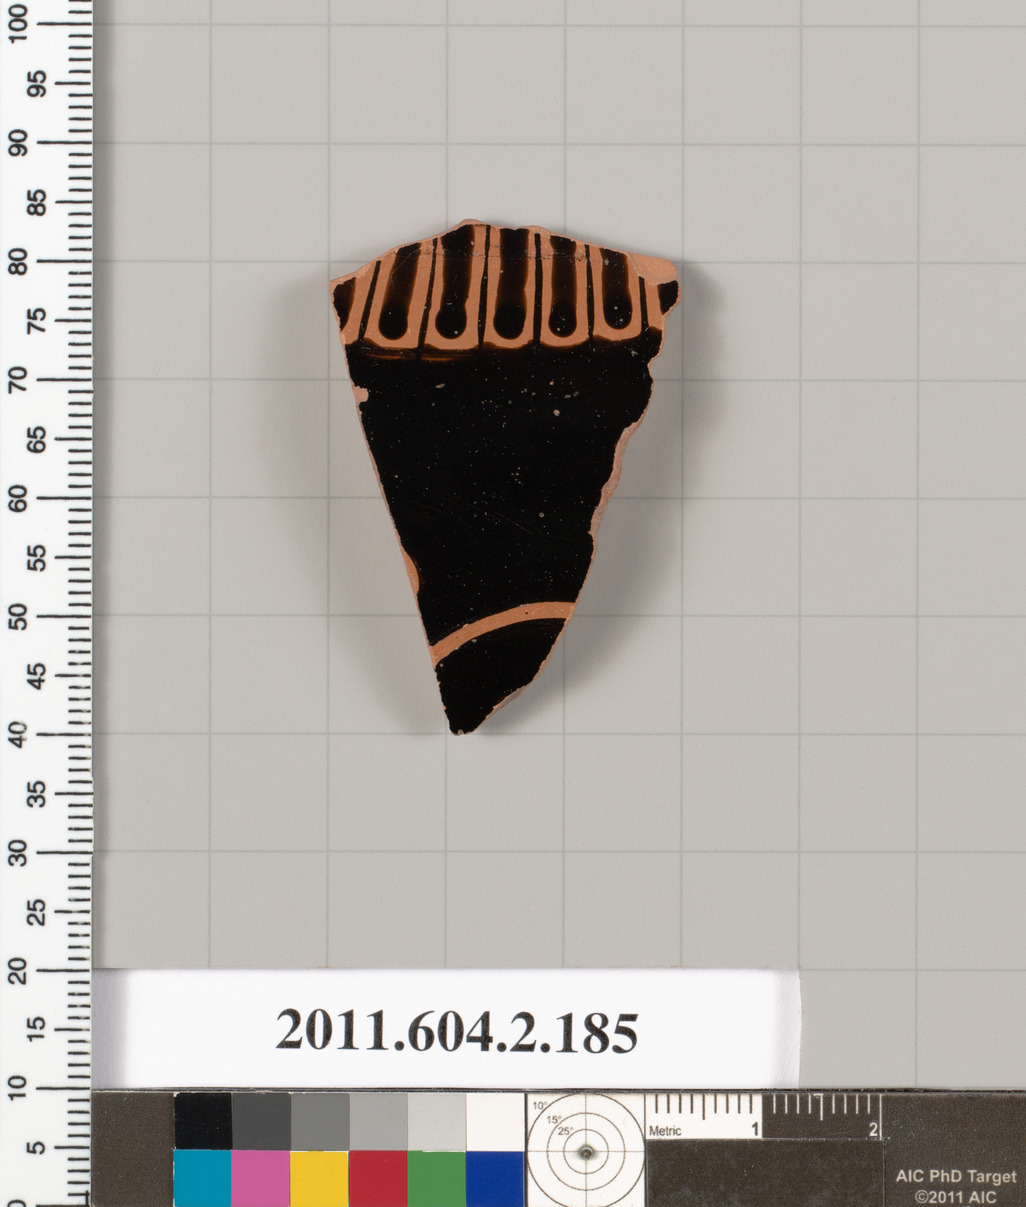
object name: stamnos fragment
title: Terracotta fragment of a stamnos (jar)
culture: greek, attic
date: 500-470 BCE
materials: terracotta